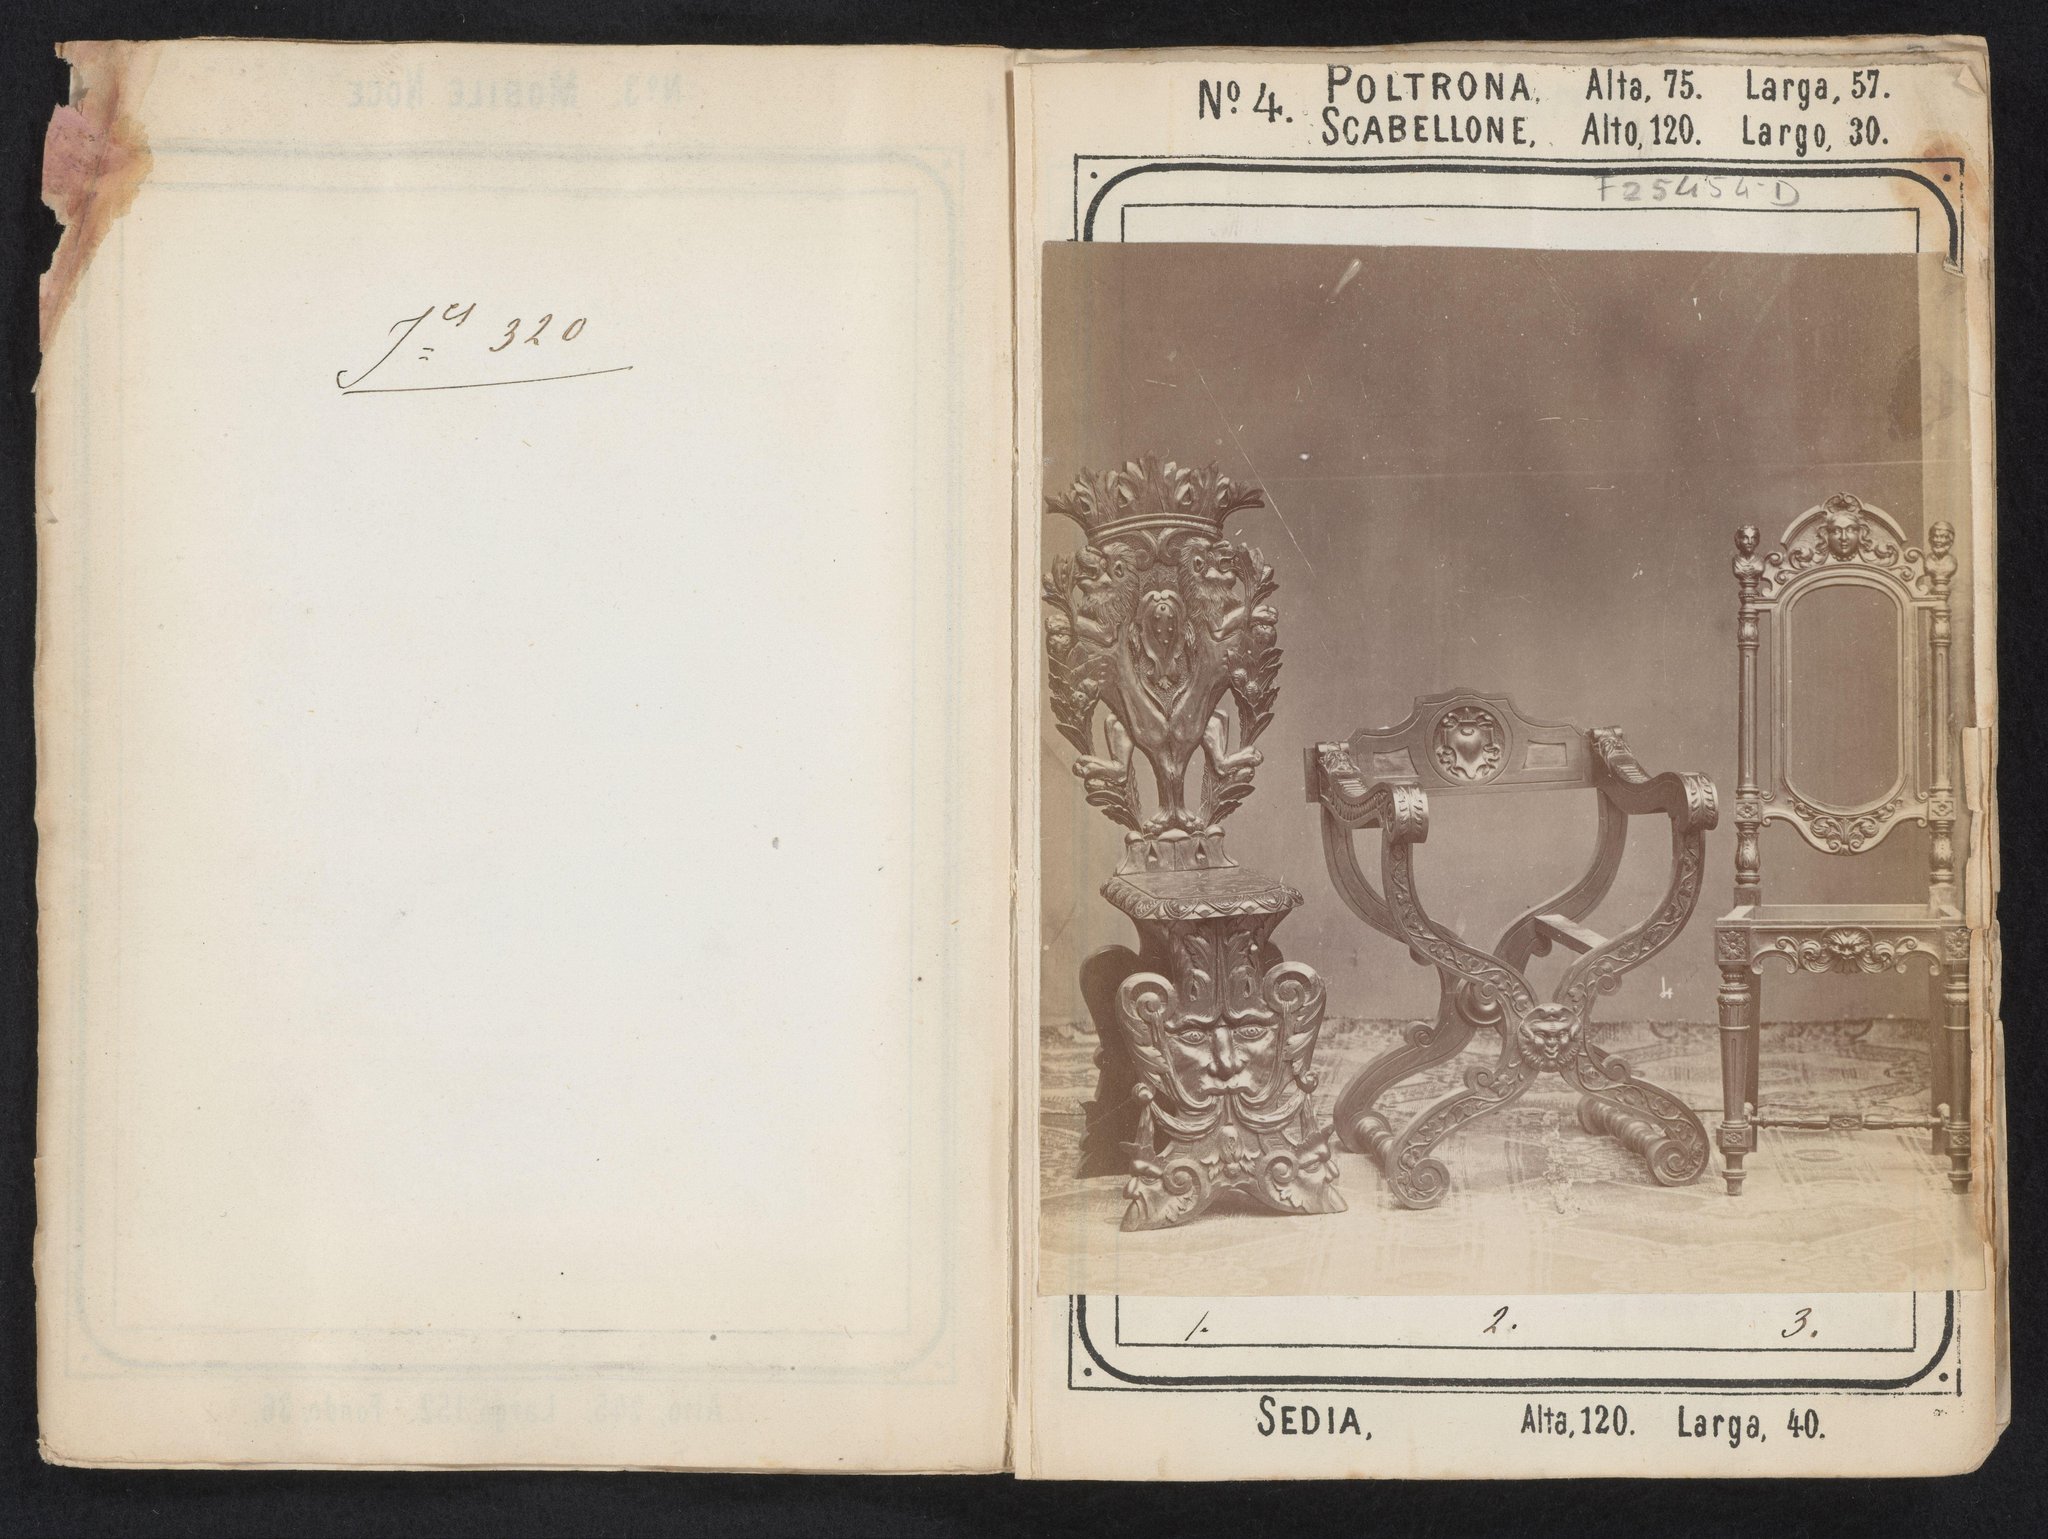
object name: photograph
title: No 4 Poltrona, Scabellone, Sedia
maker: Anonymous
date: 1878-1885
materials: paper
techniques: albumen print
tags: chair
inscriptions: inscription: ‘No. 1. Ia 30/ " 2. " 35/ " 3. " 50’, number: ‘1. 2. 3.’, inscription: ‘Alta, 75. Larga, 57./ Alto, 120. Largo, 30./ Alta, 120. Larga, 40.’